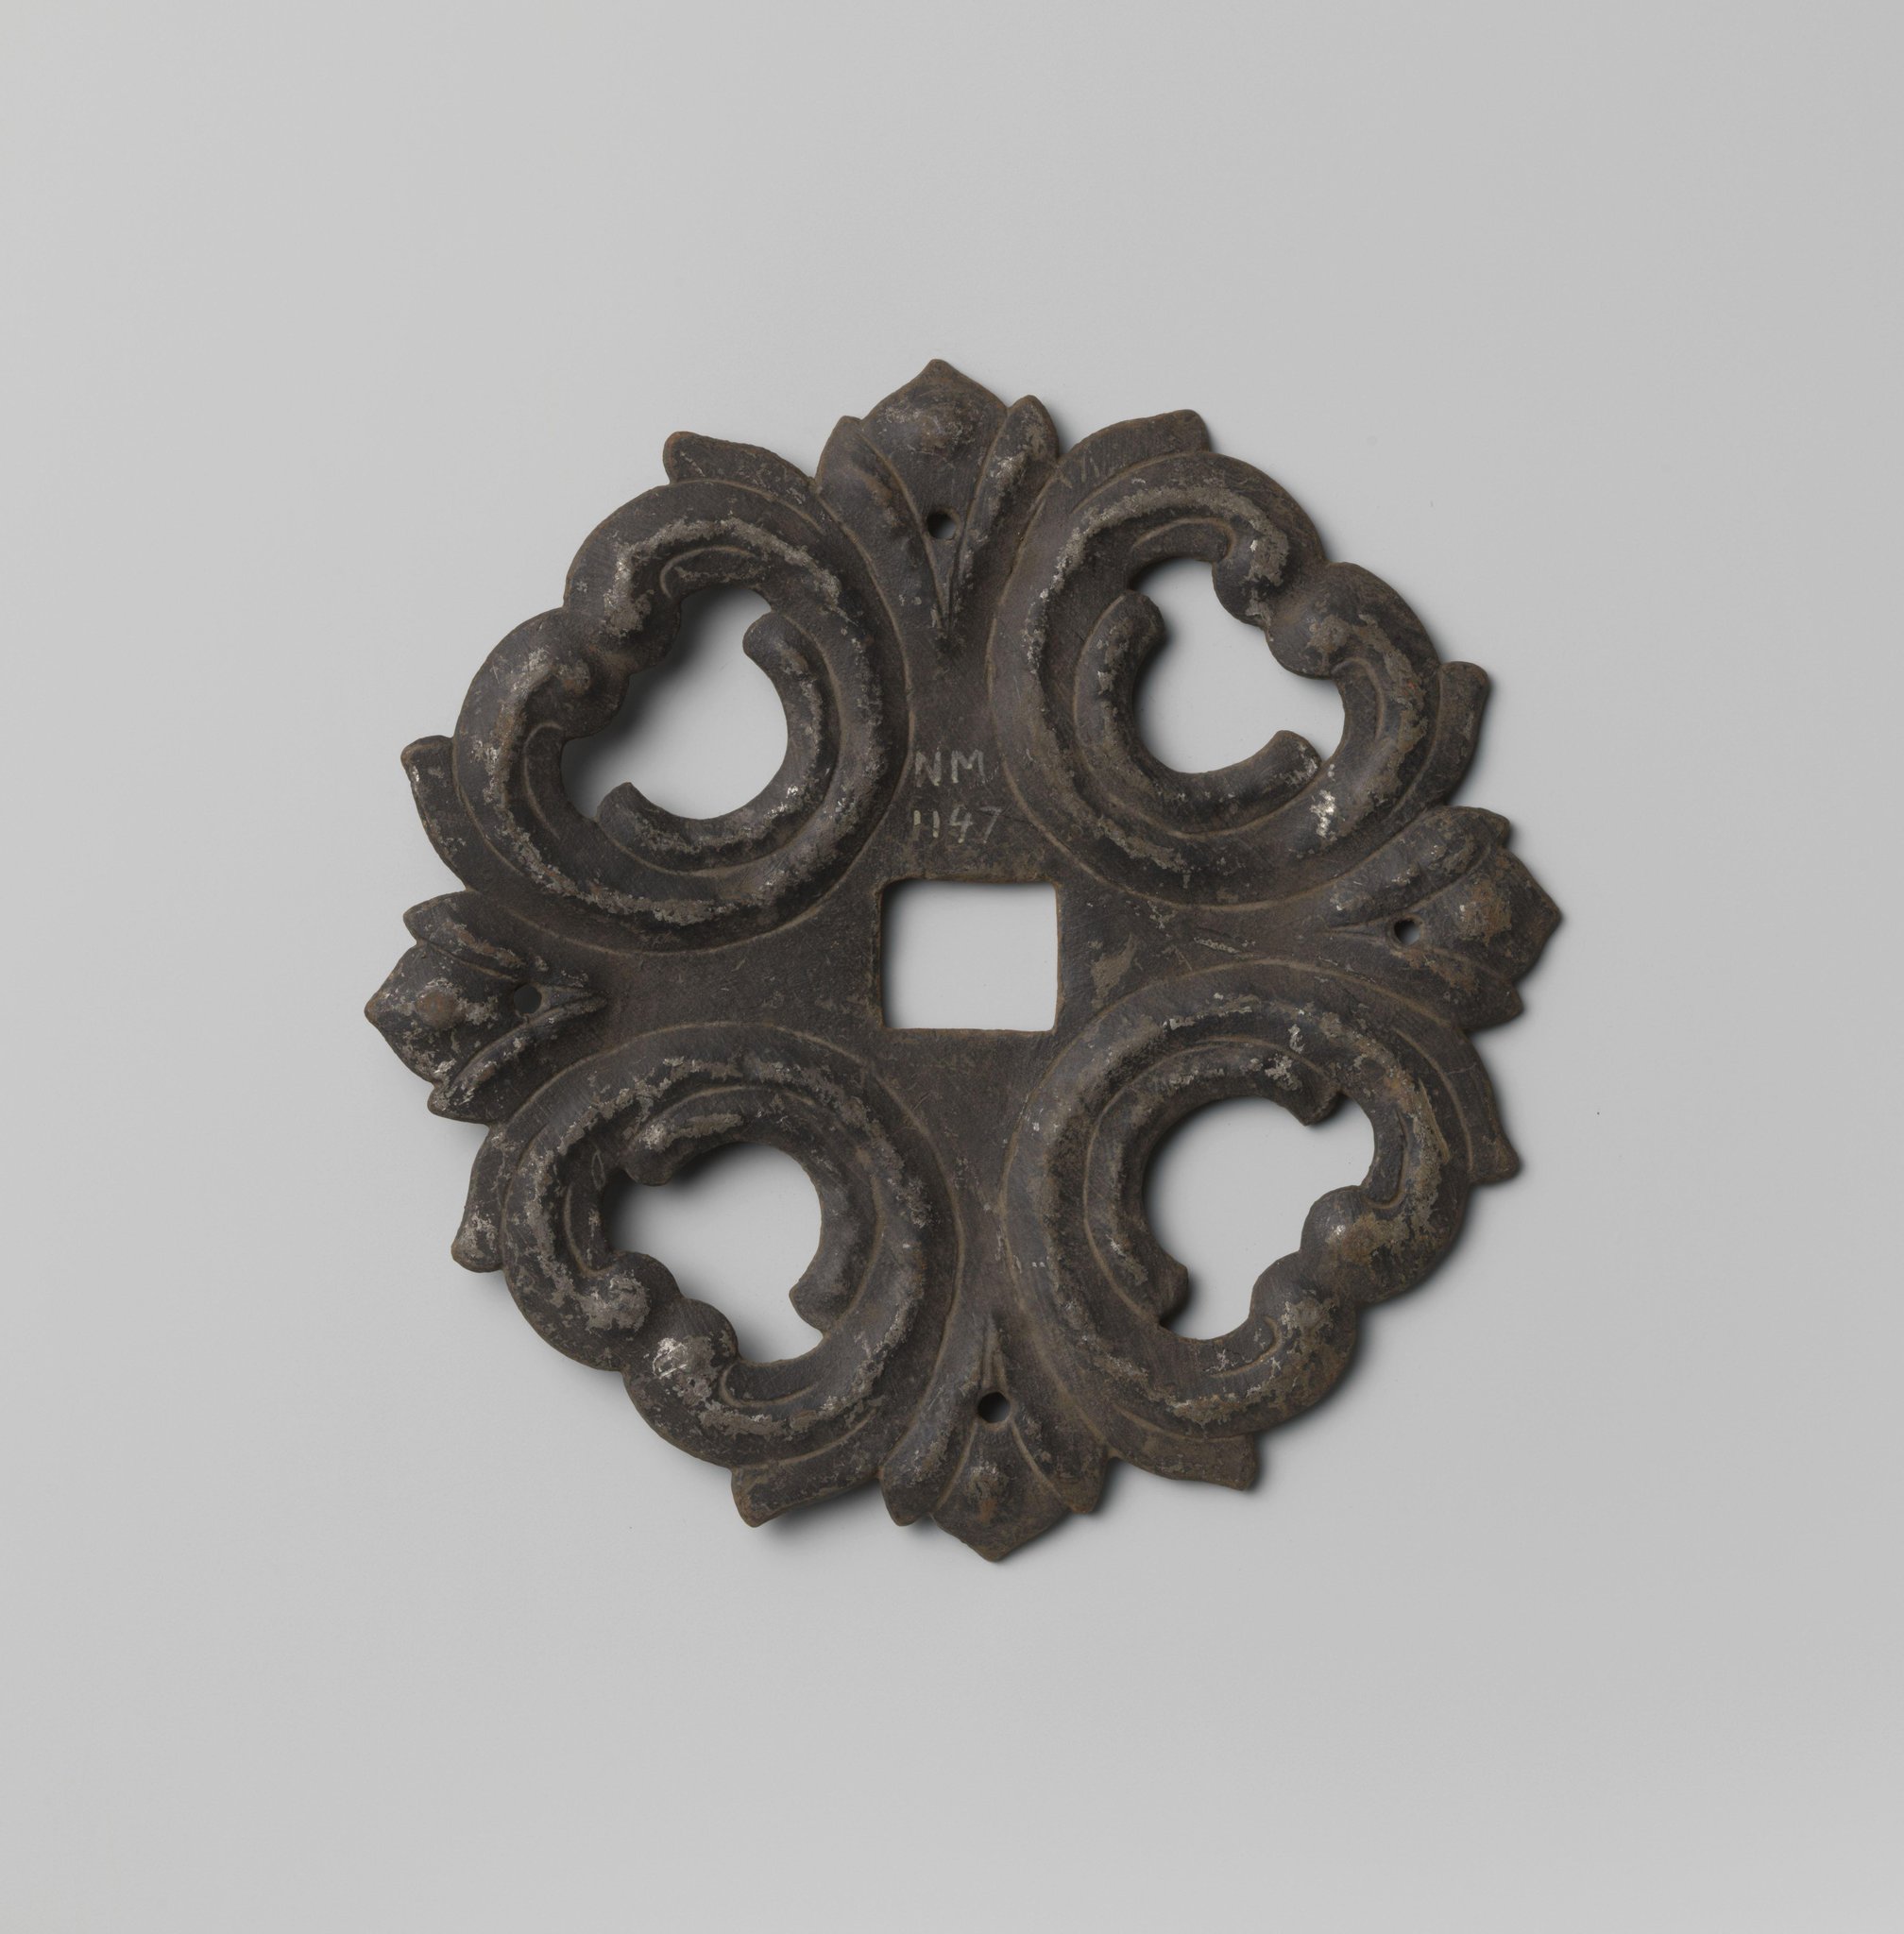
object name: door knocker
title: Beslag van vertind ijzeren deurklopper, versierd met bladmotieven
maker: Anonymous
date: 1600-1800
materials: iron, tin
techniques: forging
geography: western europe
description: Beslag voor een deurklopper van vertind ijzer. In het midden vierkante opening. Daaromheen vier gesloten C-voluten met daartussen vier driebladen.